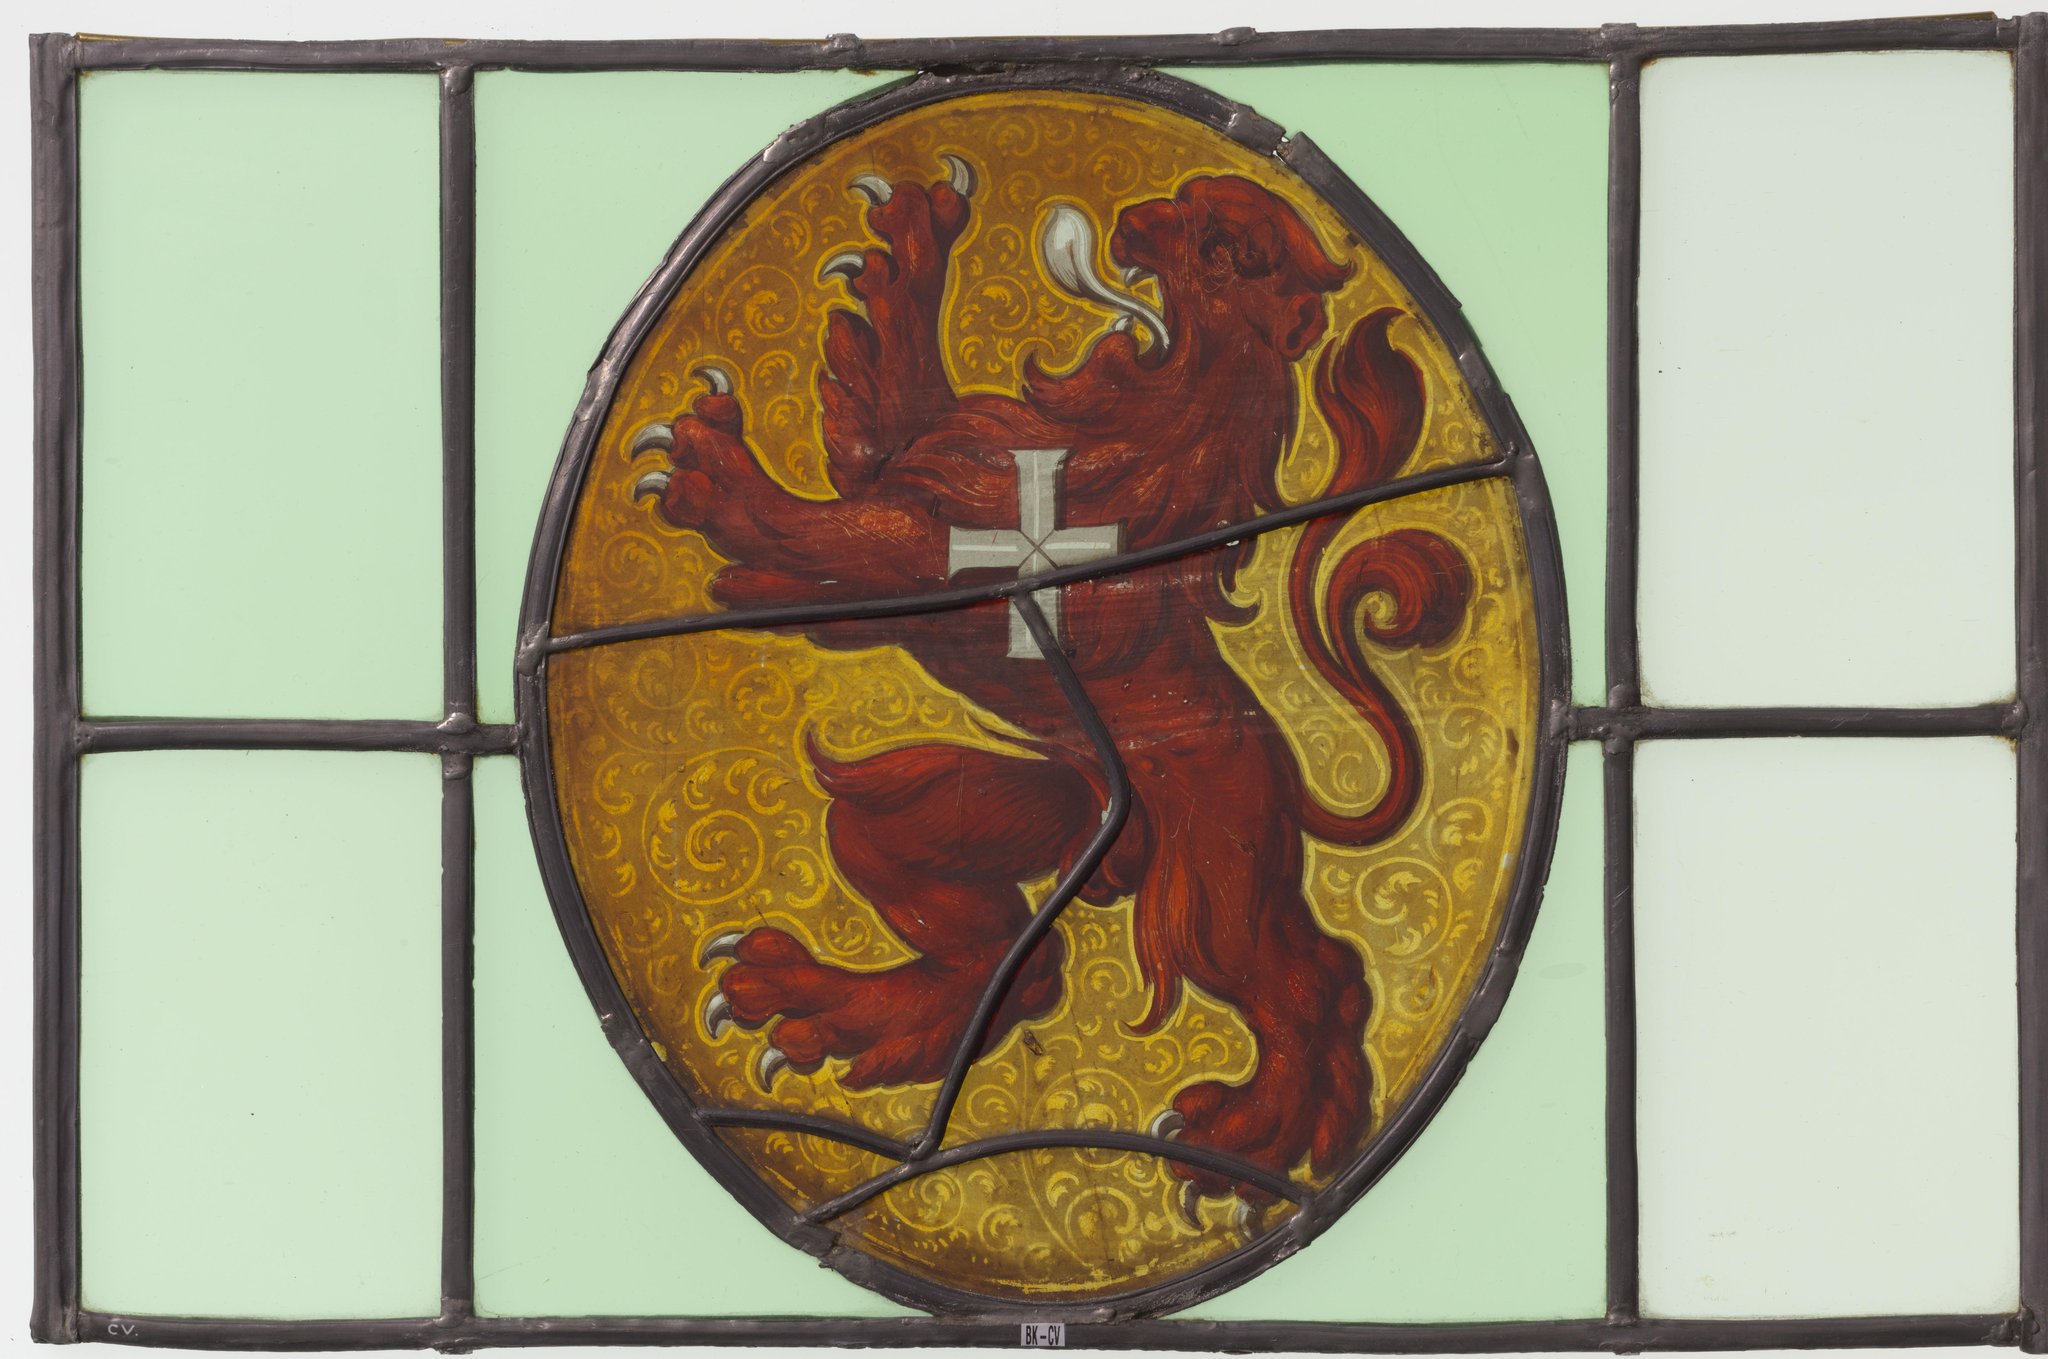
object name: wapenruit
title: Ruit met klimmende rode leeuw met wit kruis op goud veld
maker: Anonymous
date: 1700-1900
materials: glass, lead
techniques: leading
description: Een ruit waarin een ovale geschilderde wapenruit met een klimmende rode leeuw met wit kruis op een goud veld.